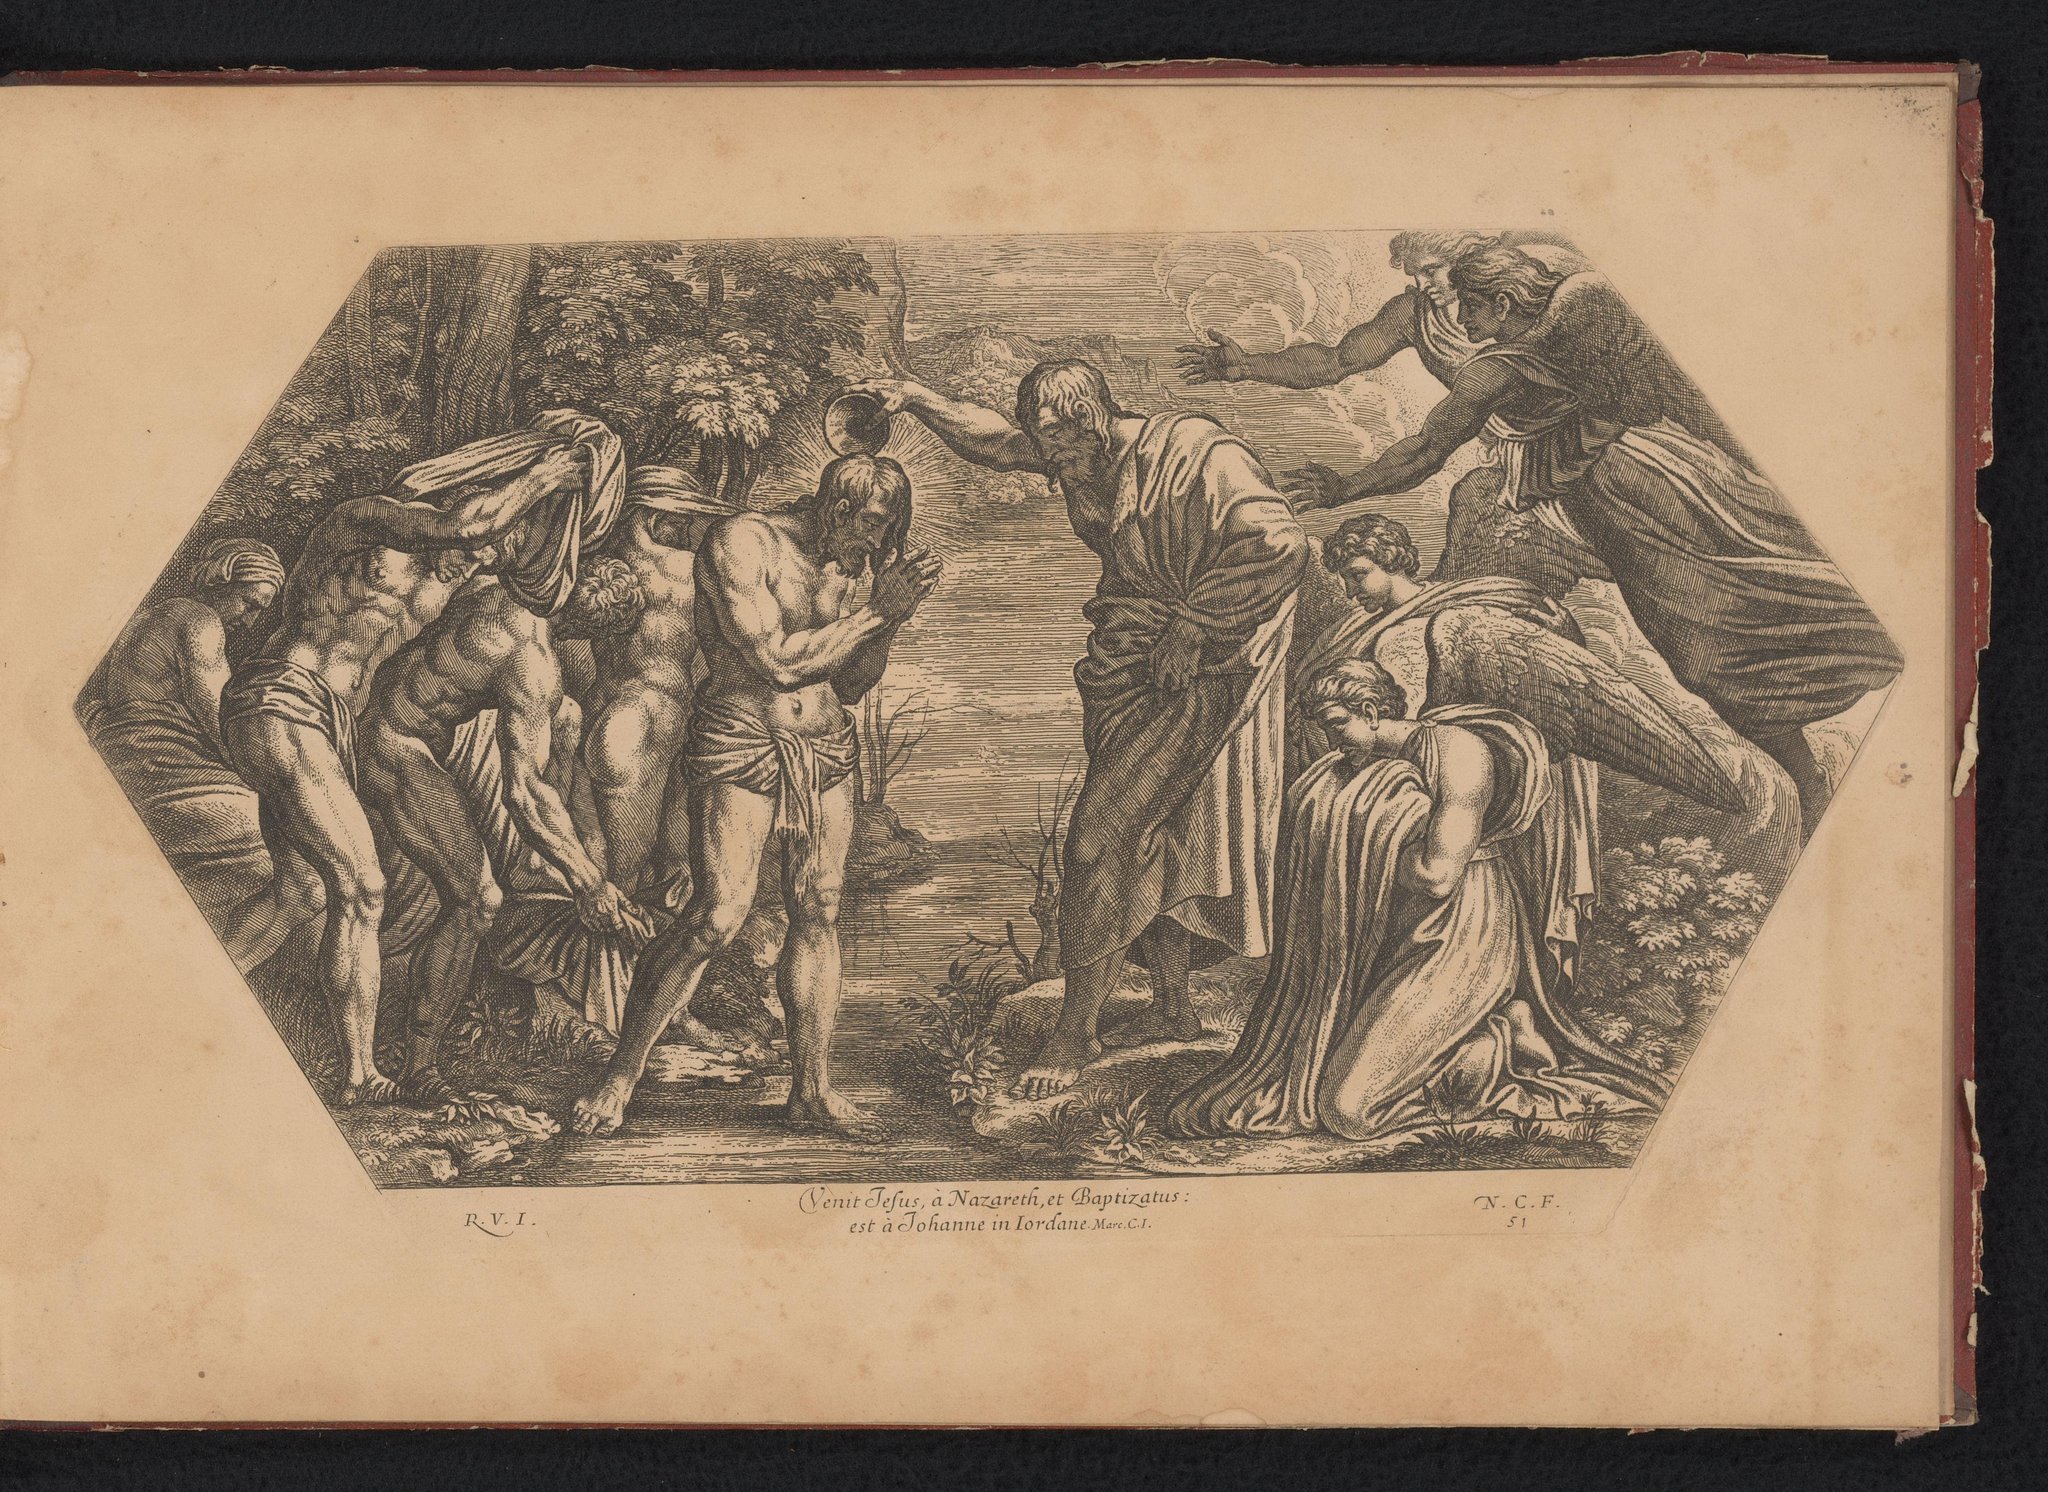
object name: print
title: Rafaël Bijbel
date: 1649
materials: paper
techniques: etching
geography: paris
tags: baptism of christ in the river jordan: john the baptist pouring out water on christ's head: the holy ghost descends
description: Deze prent maakt deel uit van een album.